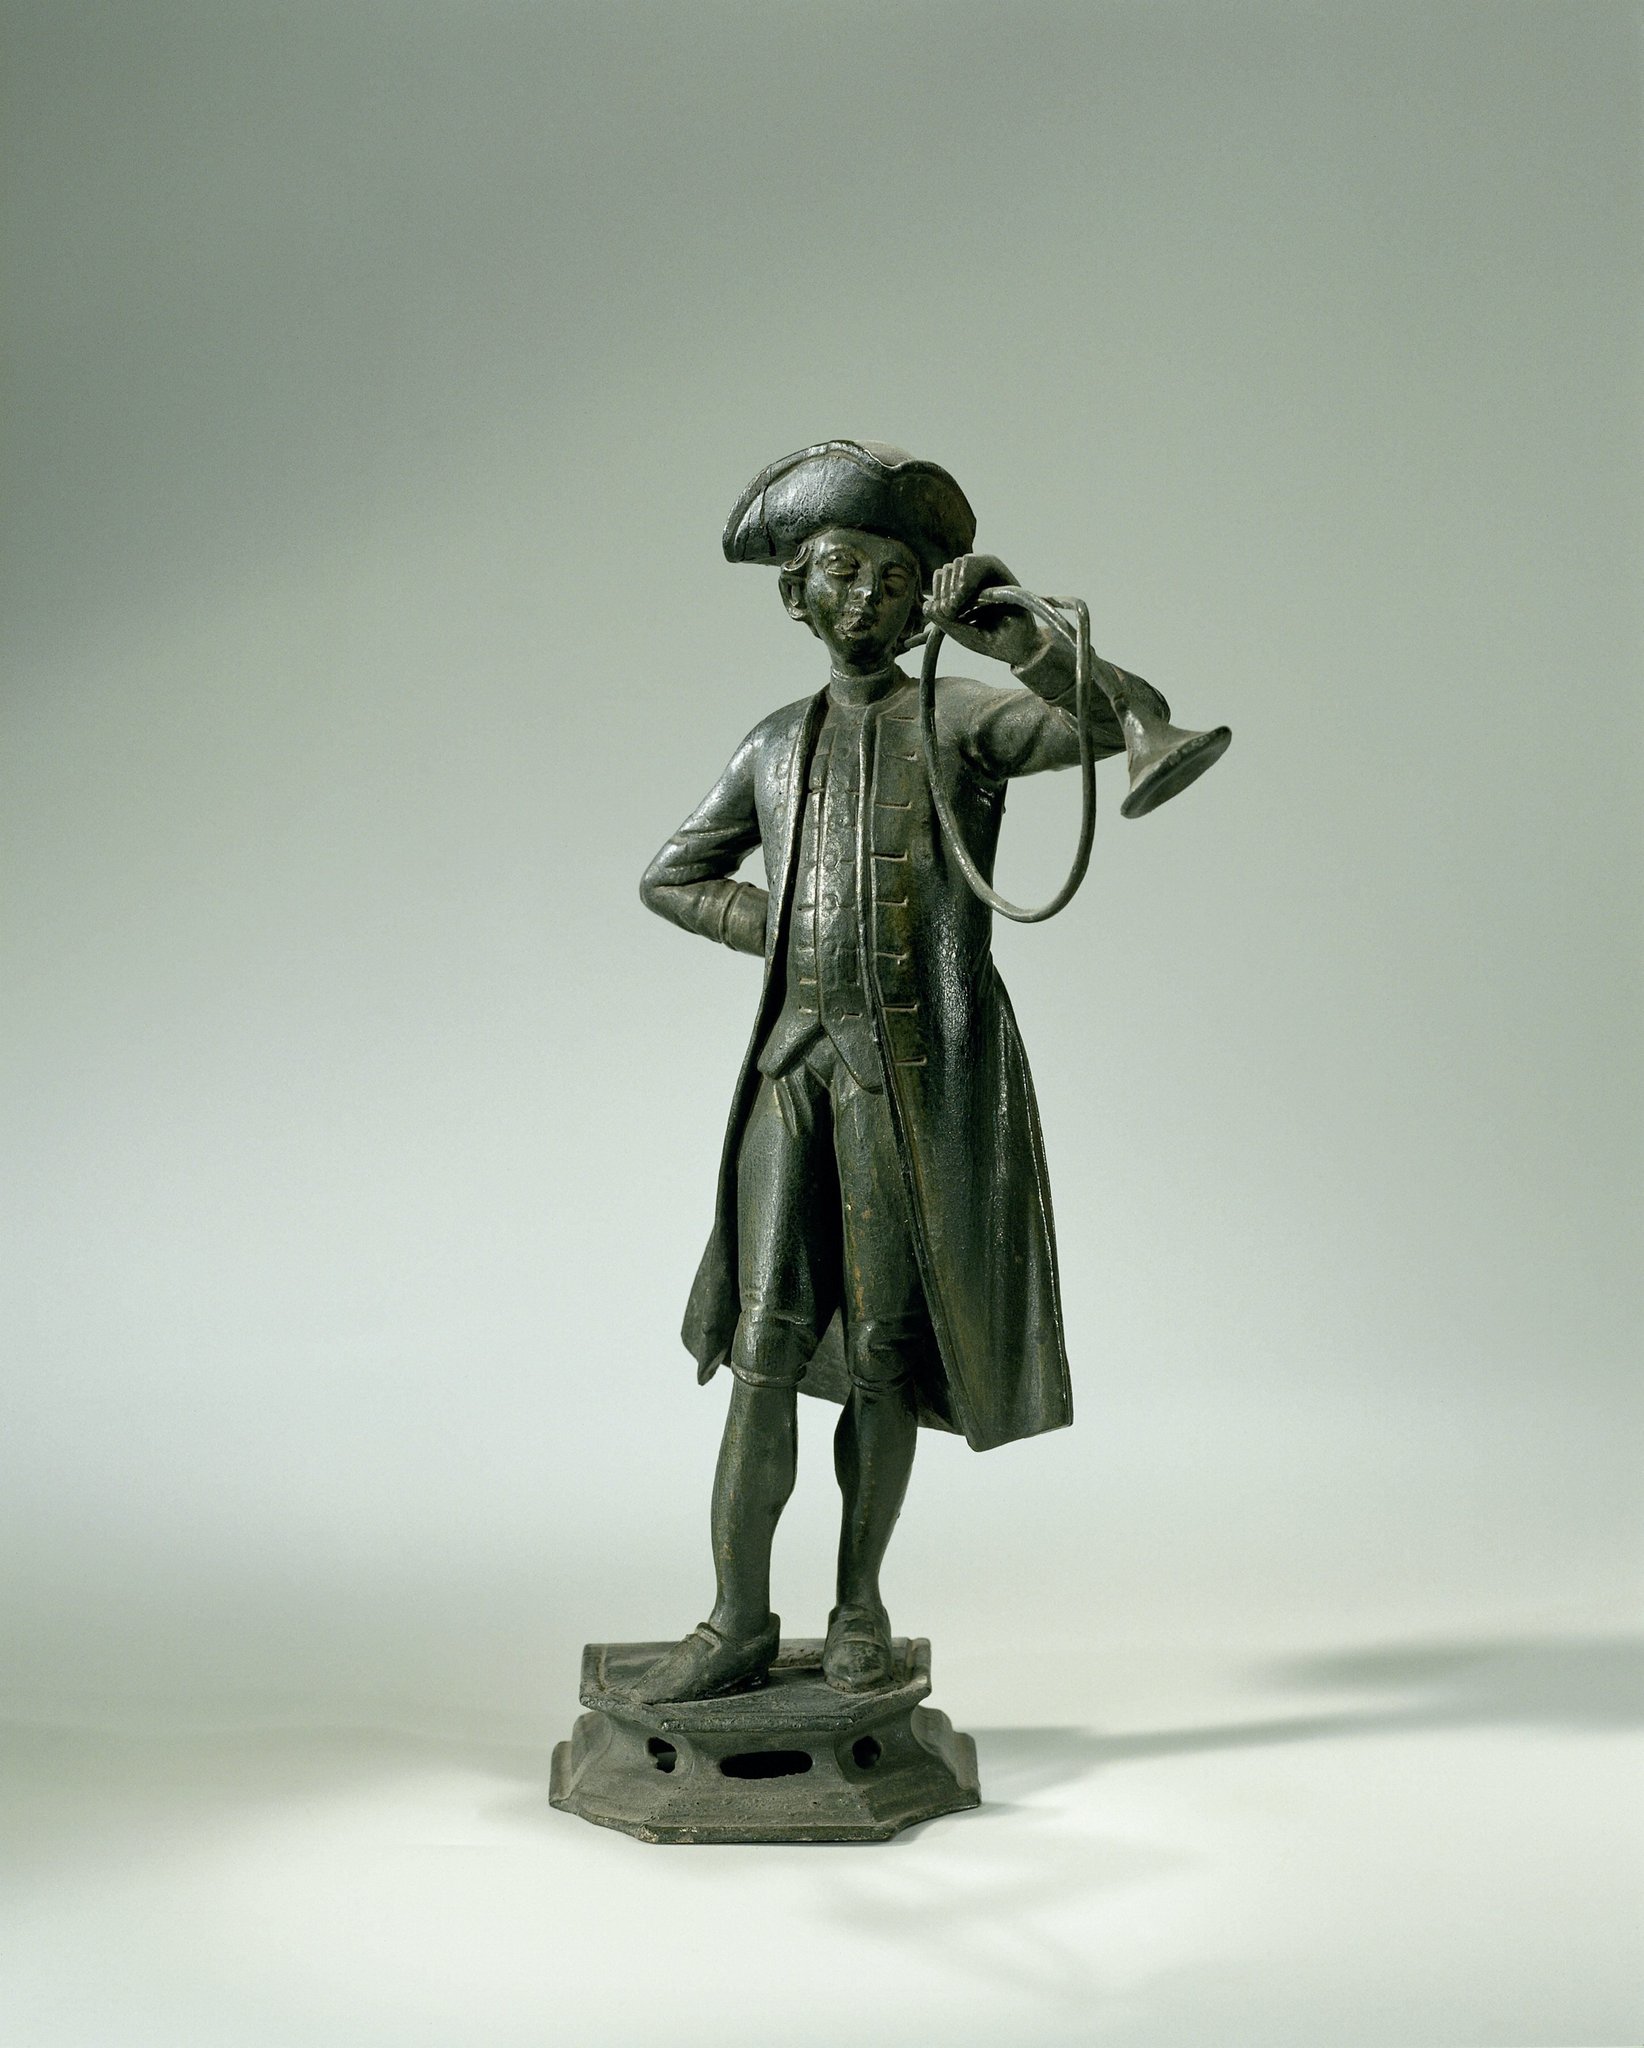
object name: sculpture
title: Figuur van een man spelend op een posthoorn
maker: Anonymous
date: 1700-1800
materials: wood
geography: oberammergau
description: Figuur van een man spelend op een posthoorn. Op opengewerkt laag voetstuk.